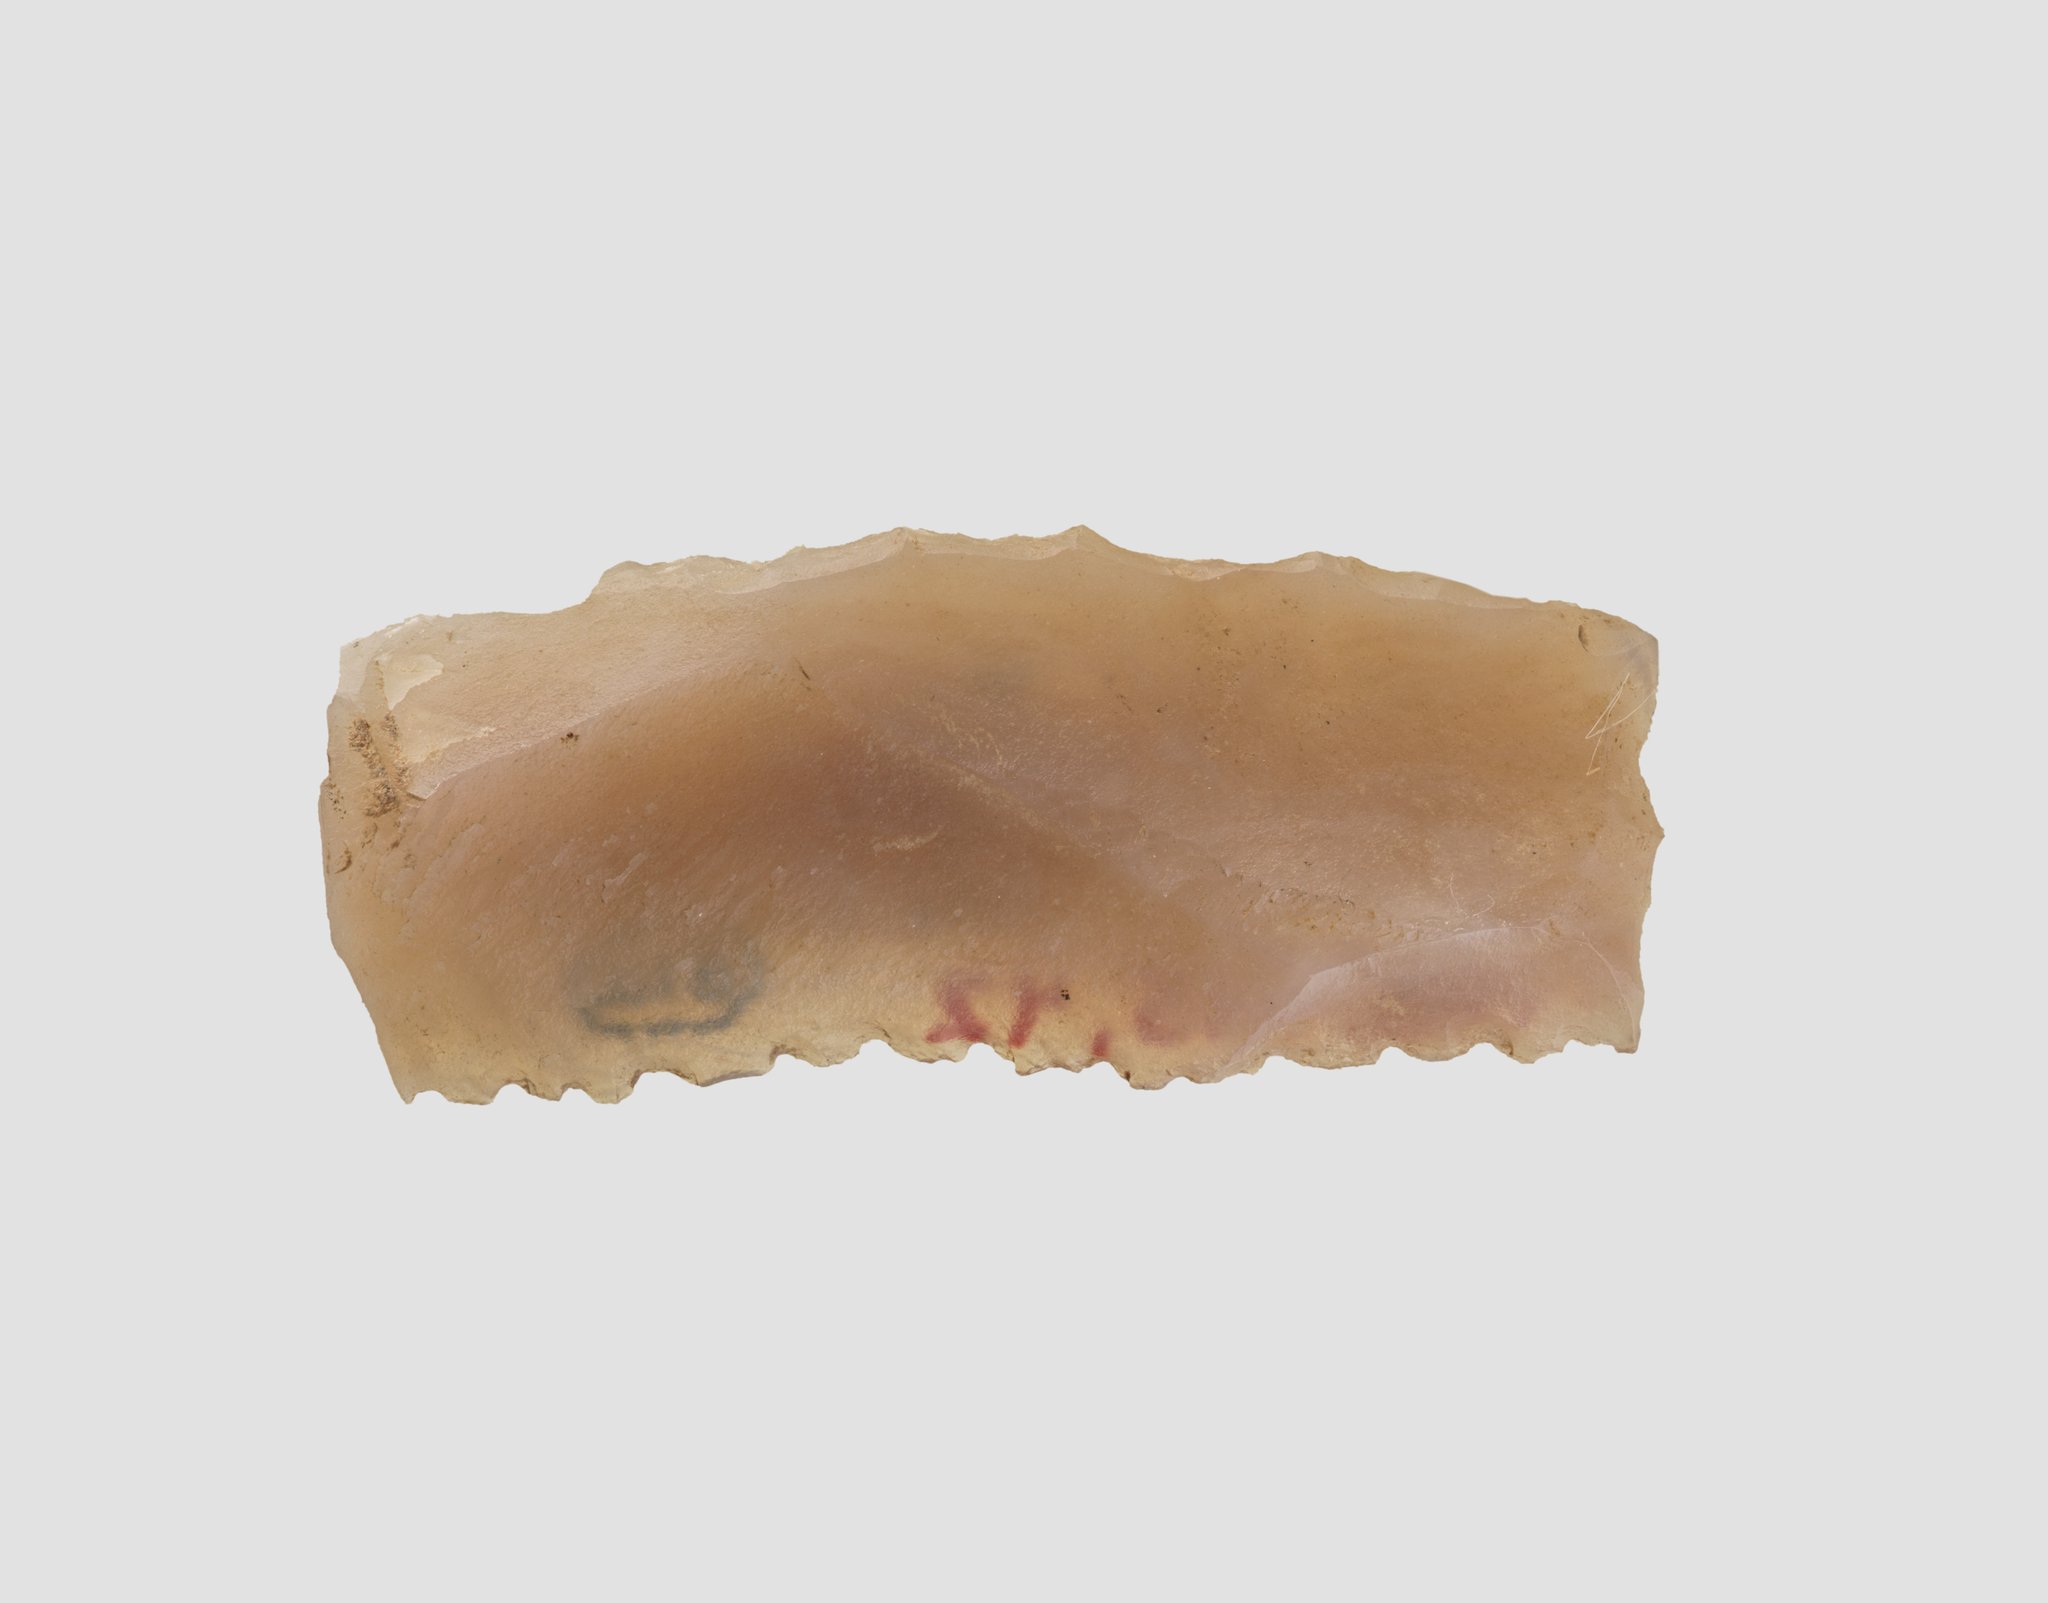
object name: knife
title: Blade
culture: ghassulian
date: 4600-3600 BCE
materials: stone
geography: levant